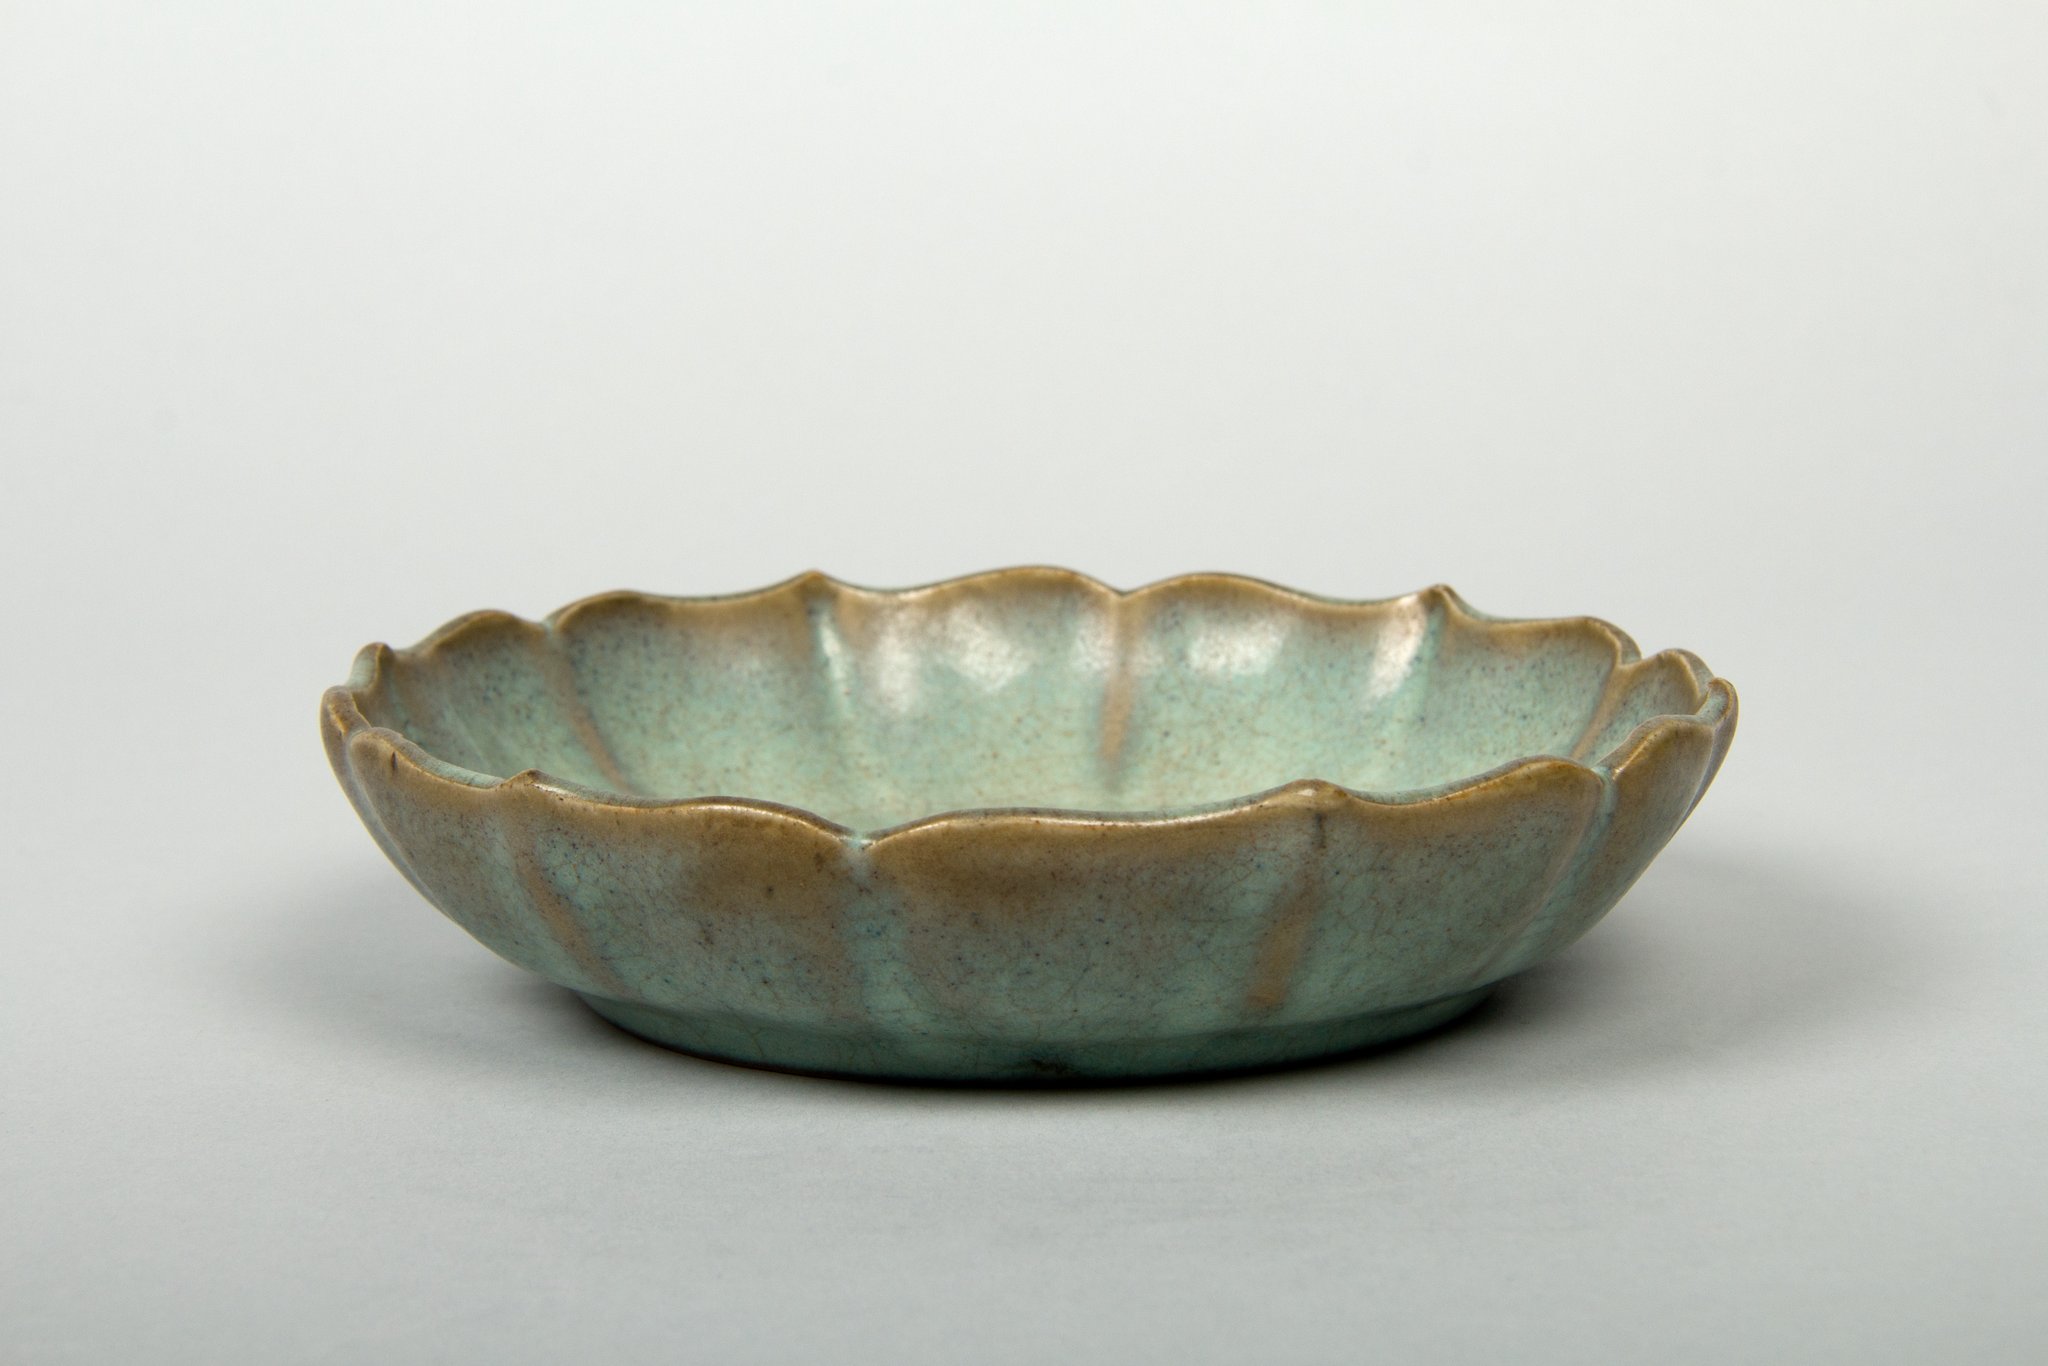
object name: dish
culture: chinese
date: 1271-1368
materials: glaze, stoneware